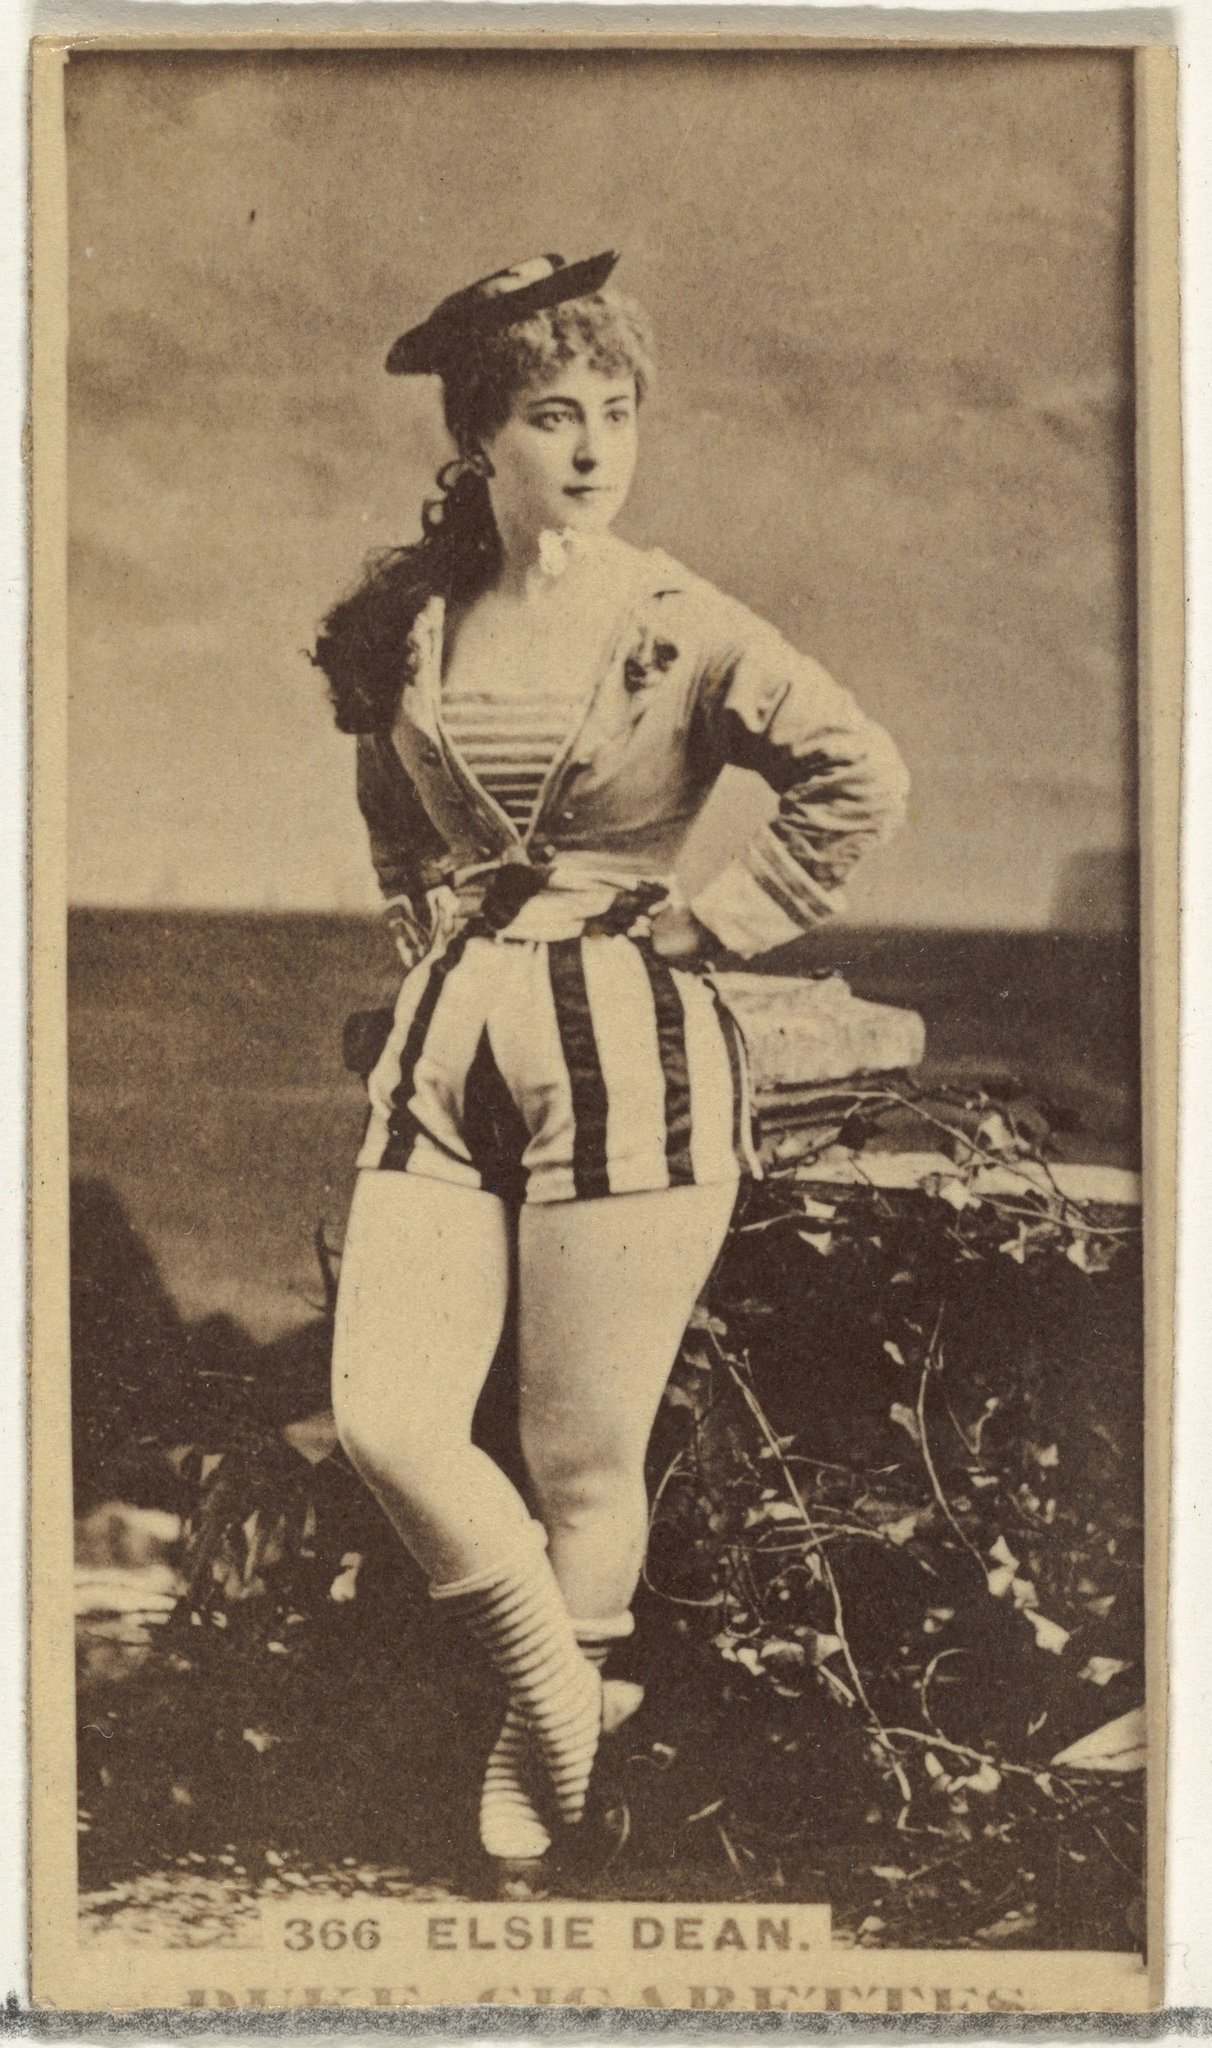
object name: photograph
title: Card Number 366, Elsie Dean, from the Actors and Actresses series (N145-7) issued by Duke Sons & Co. to promote Duke Cigarettes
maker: w. duke, sons & co.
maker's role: publisher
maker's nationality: american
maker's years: 1870-1920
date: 1880-1889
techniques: albumen silver print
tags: portraits,women,actresses